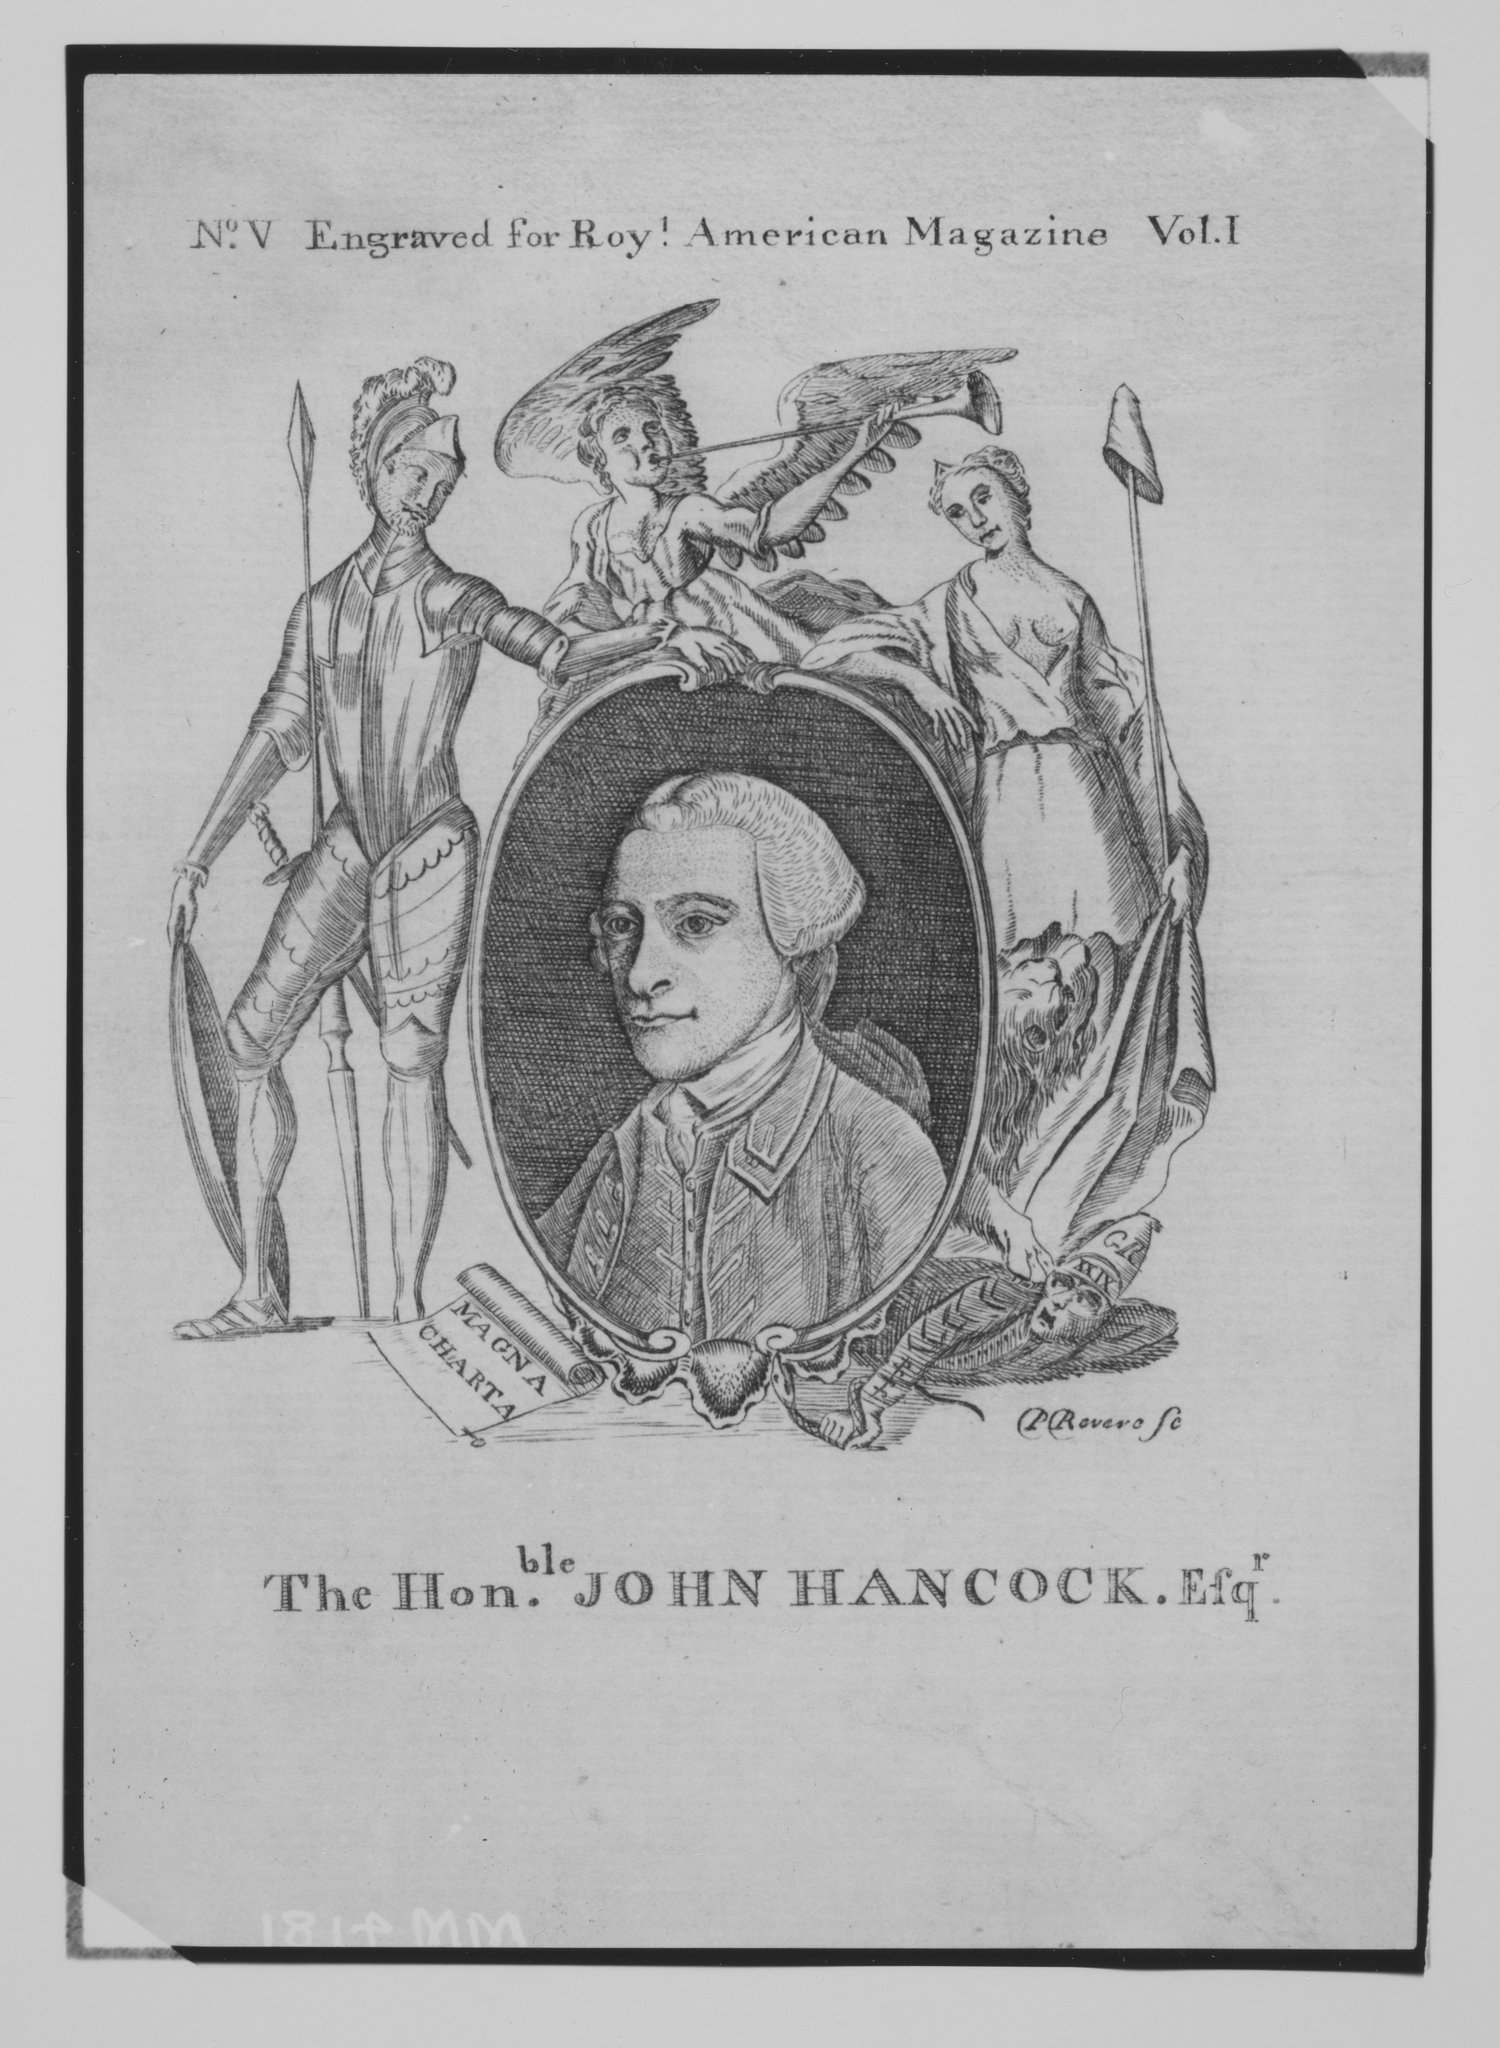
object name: print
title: The Hon-ble. John Hancock, Esq-r.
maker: paul revere jr.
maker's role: engraver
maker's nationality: american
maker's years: 1734-1818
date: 1774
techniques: engraving